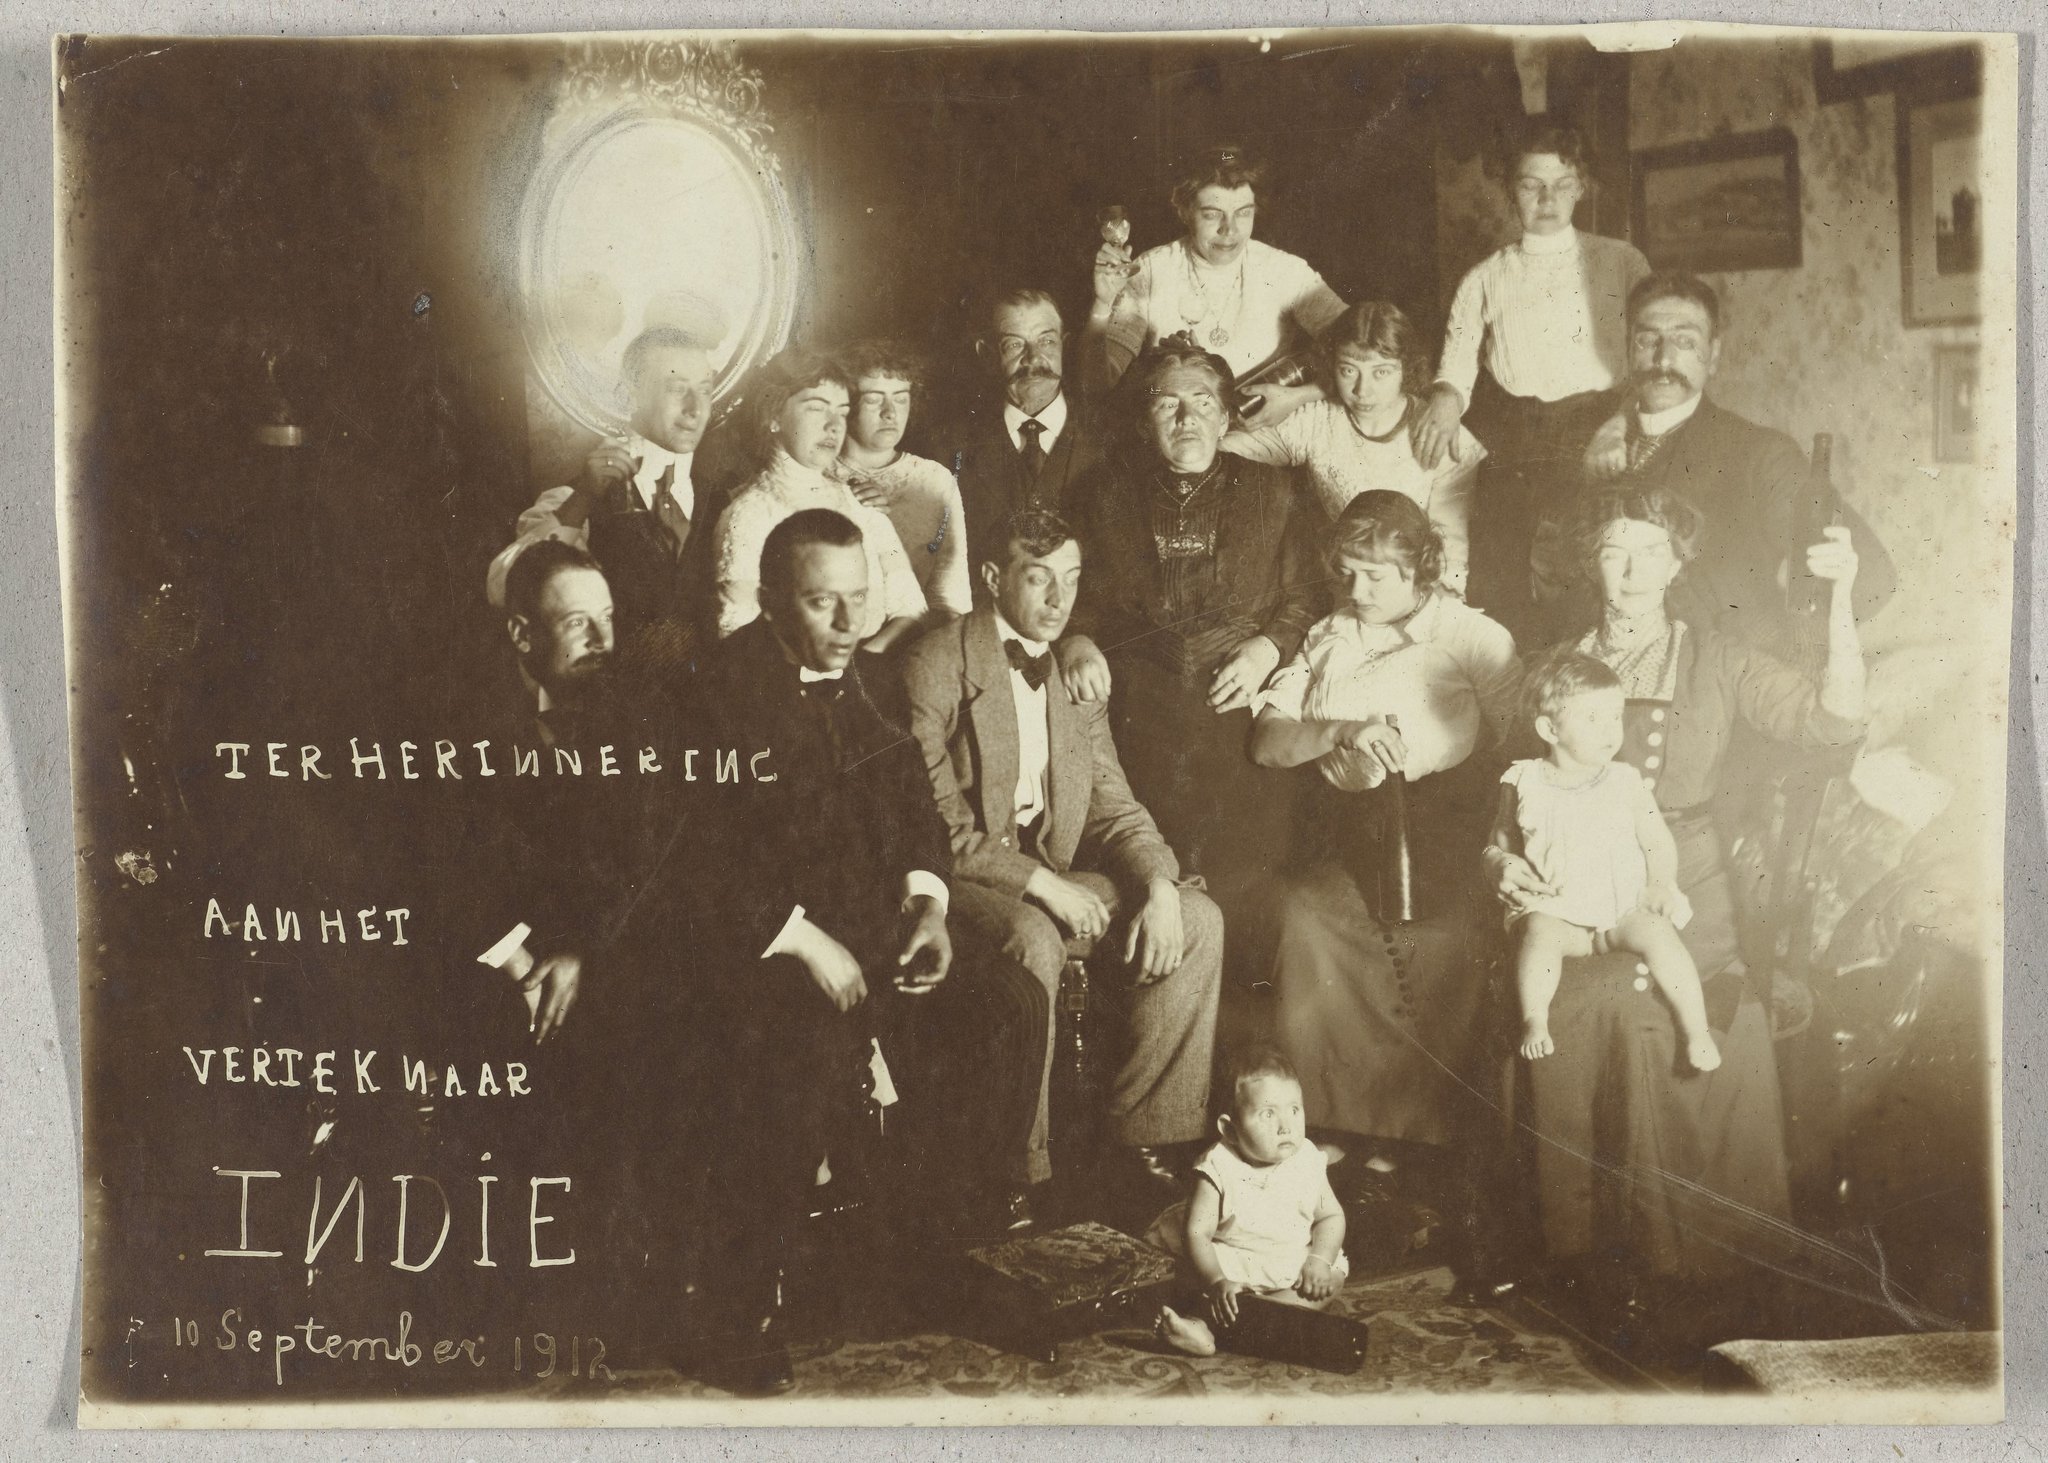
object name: photograph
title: Ter herinnering aan het vertrek naar Indië, 10 september 1912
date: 1900-1915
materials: paper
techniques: albumen print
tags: family group, especially parents with their child(ren)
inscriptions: annotation: ‘Ter herinnering aan het vertrek naar Indië, 10 september 1912’